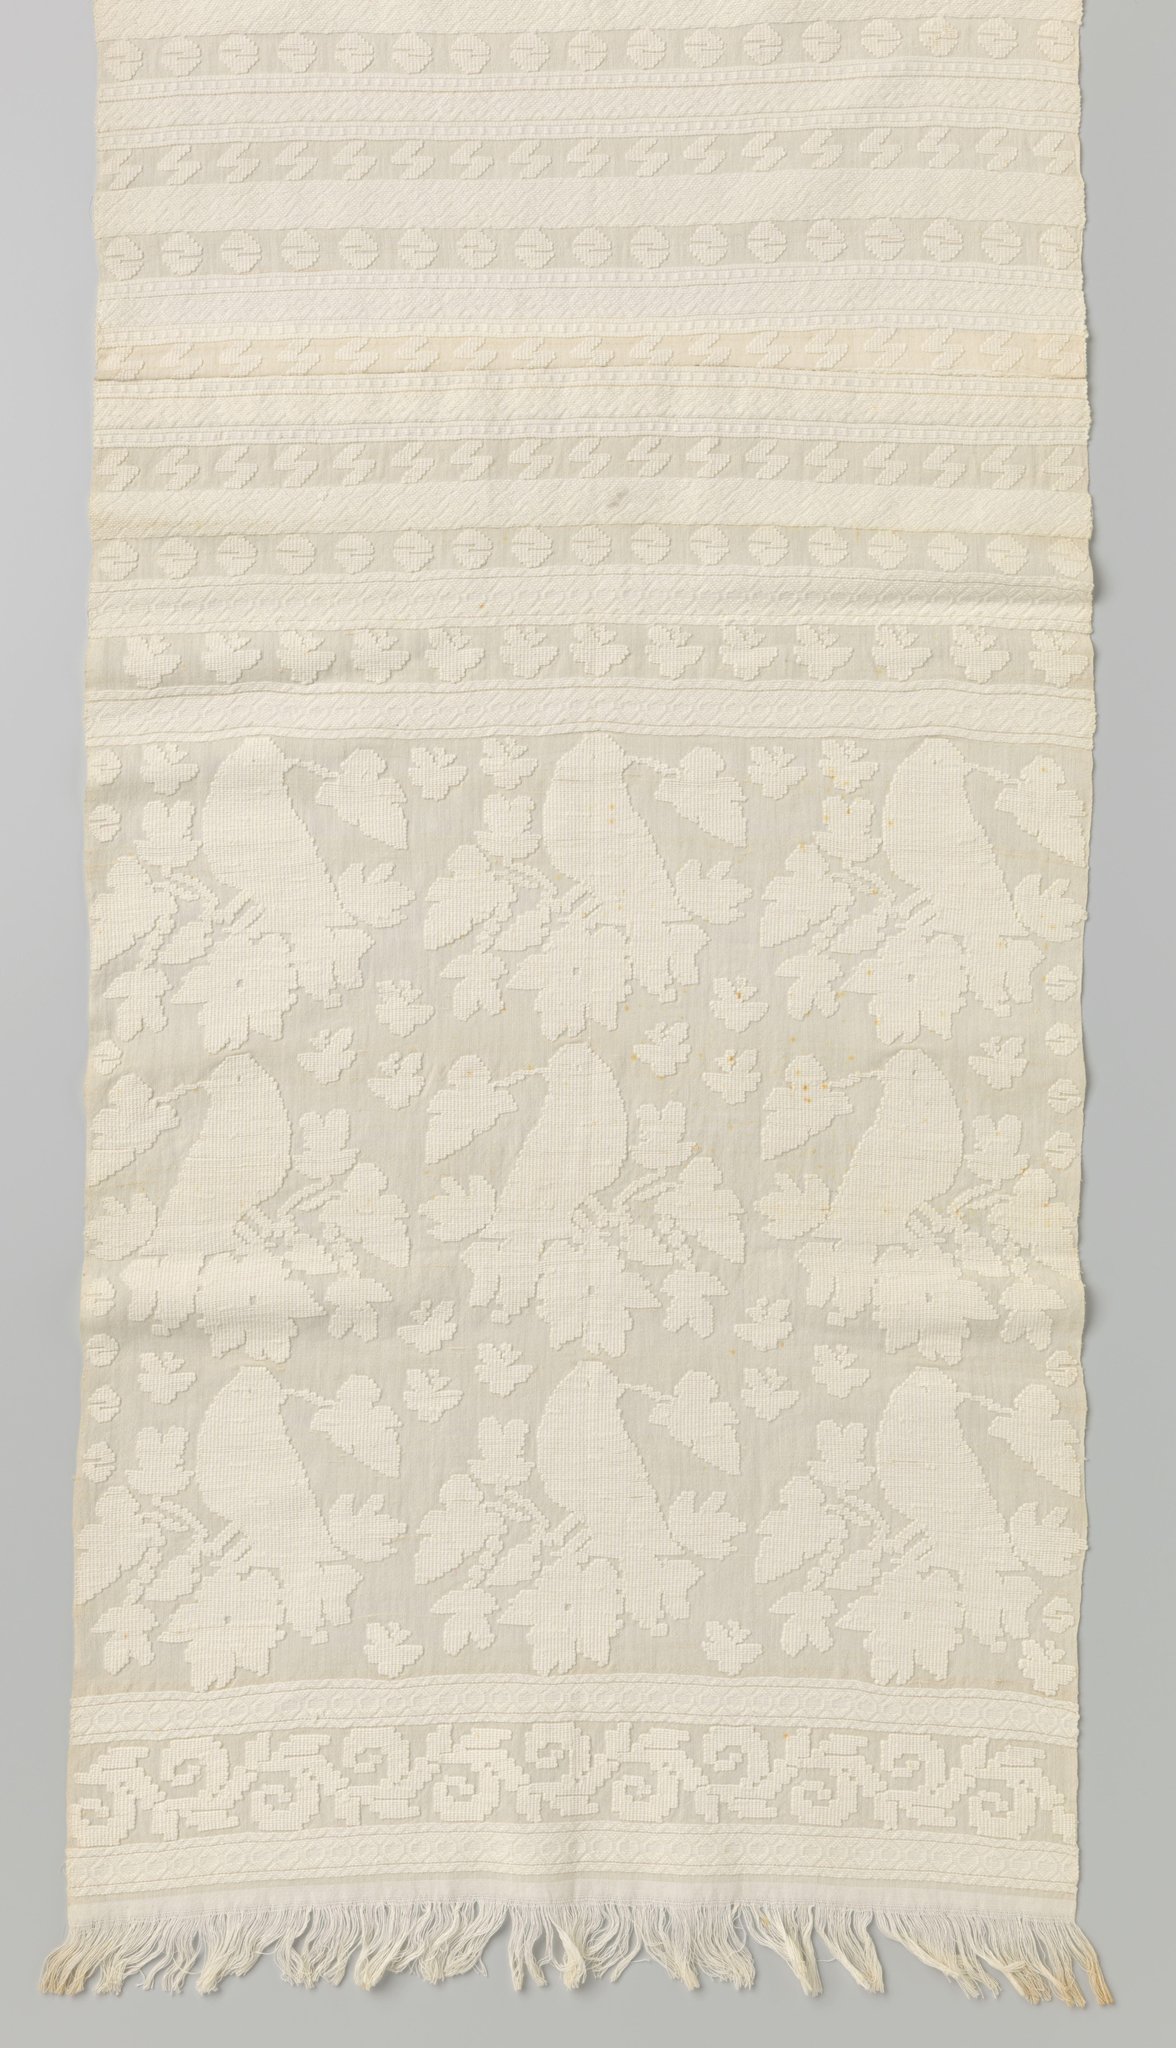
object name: kleed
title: Buffetloper van écru katoen, versierd met ingeweven reliëfmotieven met een vogel op een kruk en smalle strepen.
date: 1885-1915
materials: cotton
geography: romania